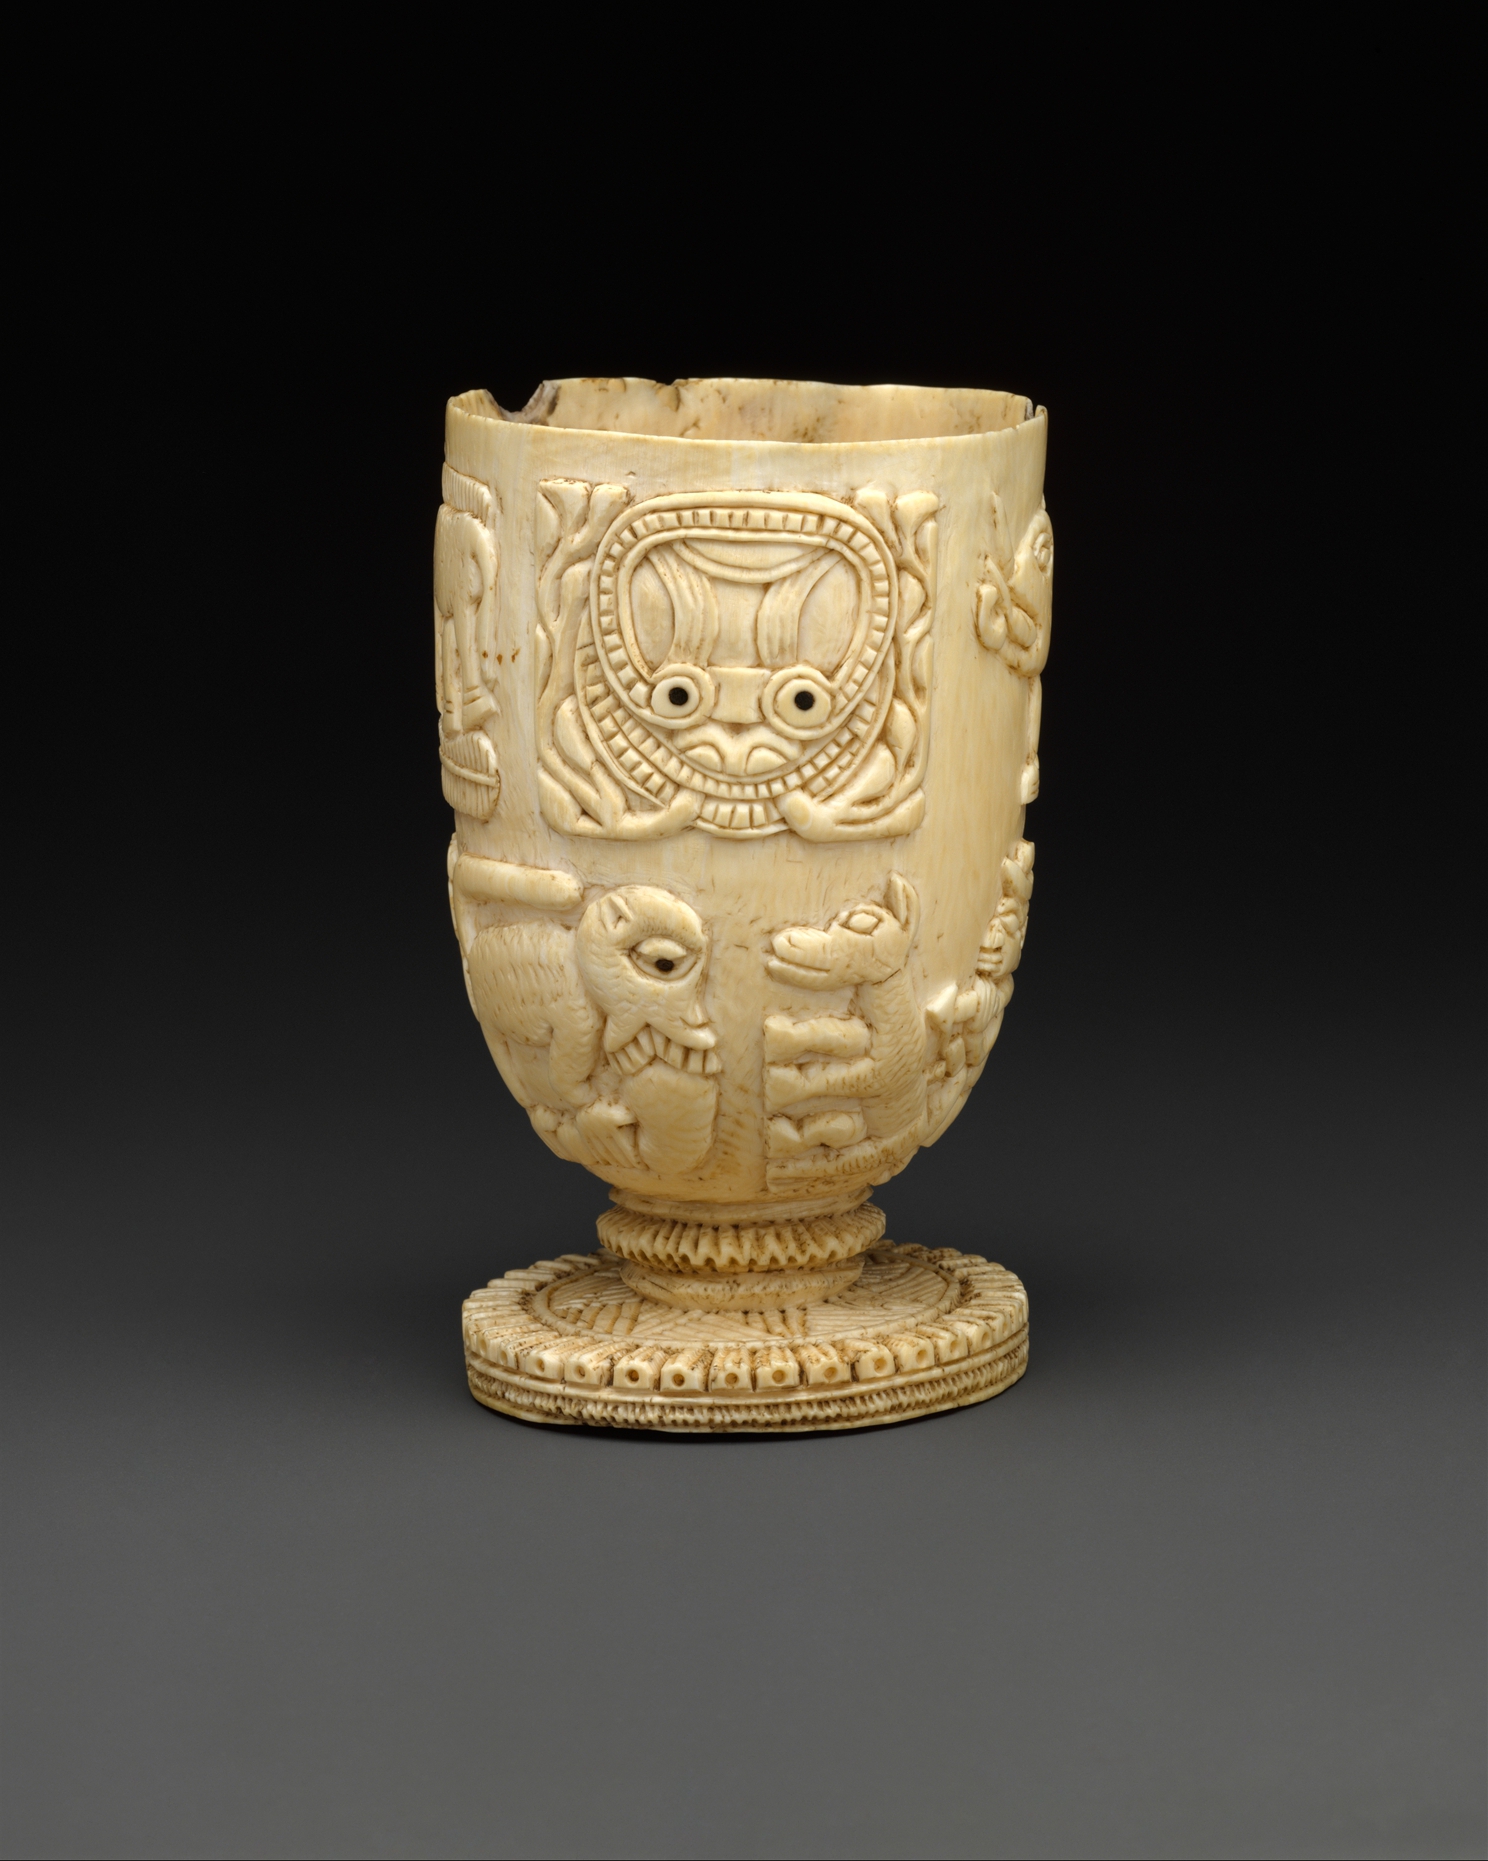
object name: vessel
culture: yoruba peoples, owo group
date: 1601-1800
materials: plant material, ivory, wood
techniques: inlay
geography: nigeria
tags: animals